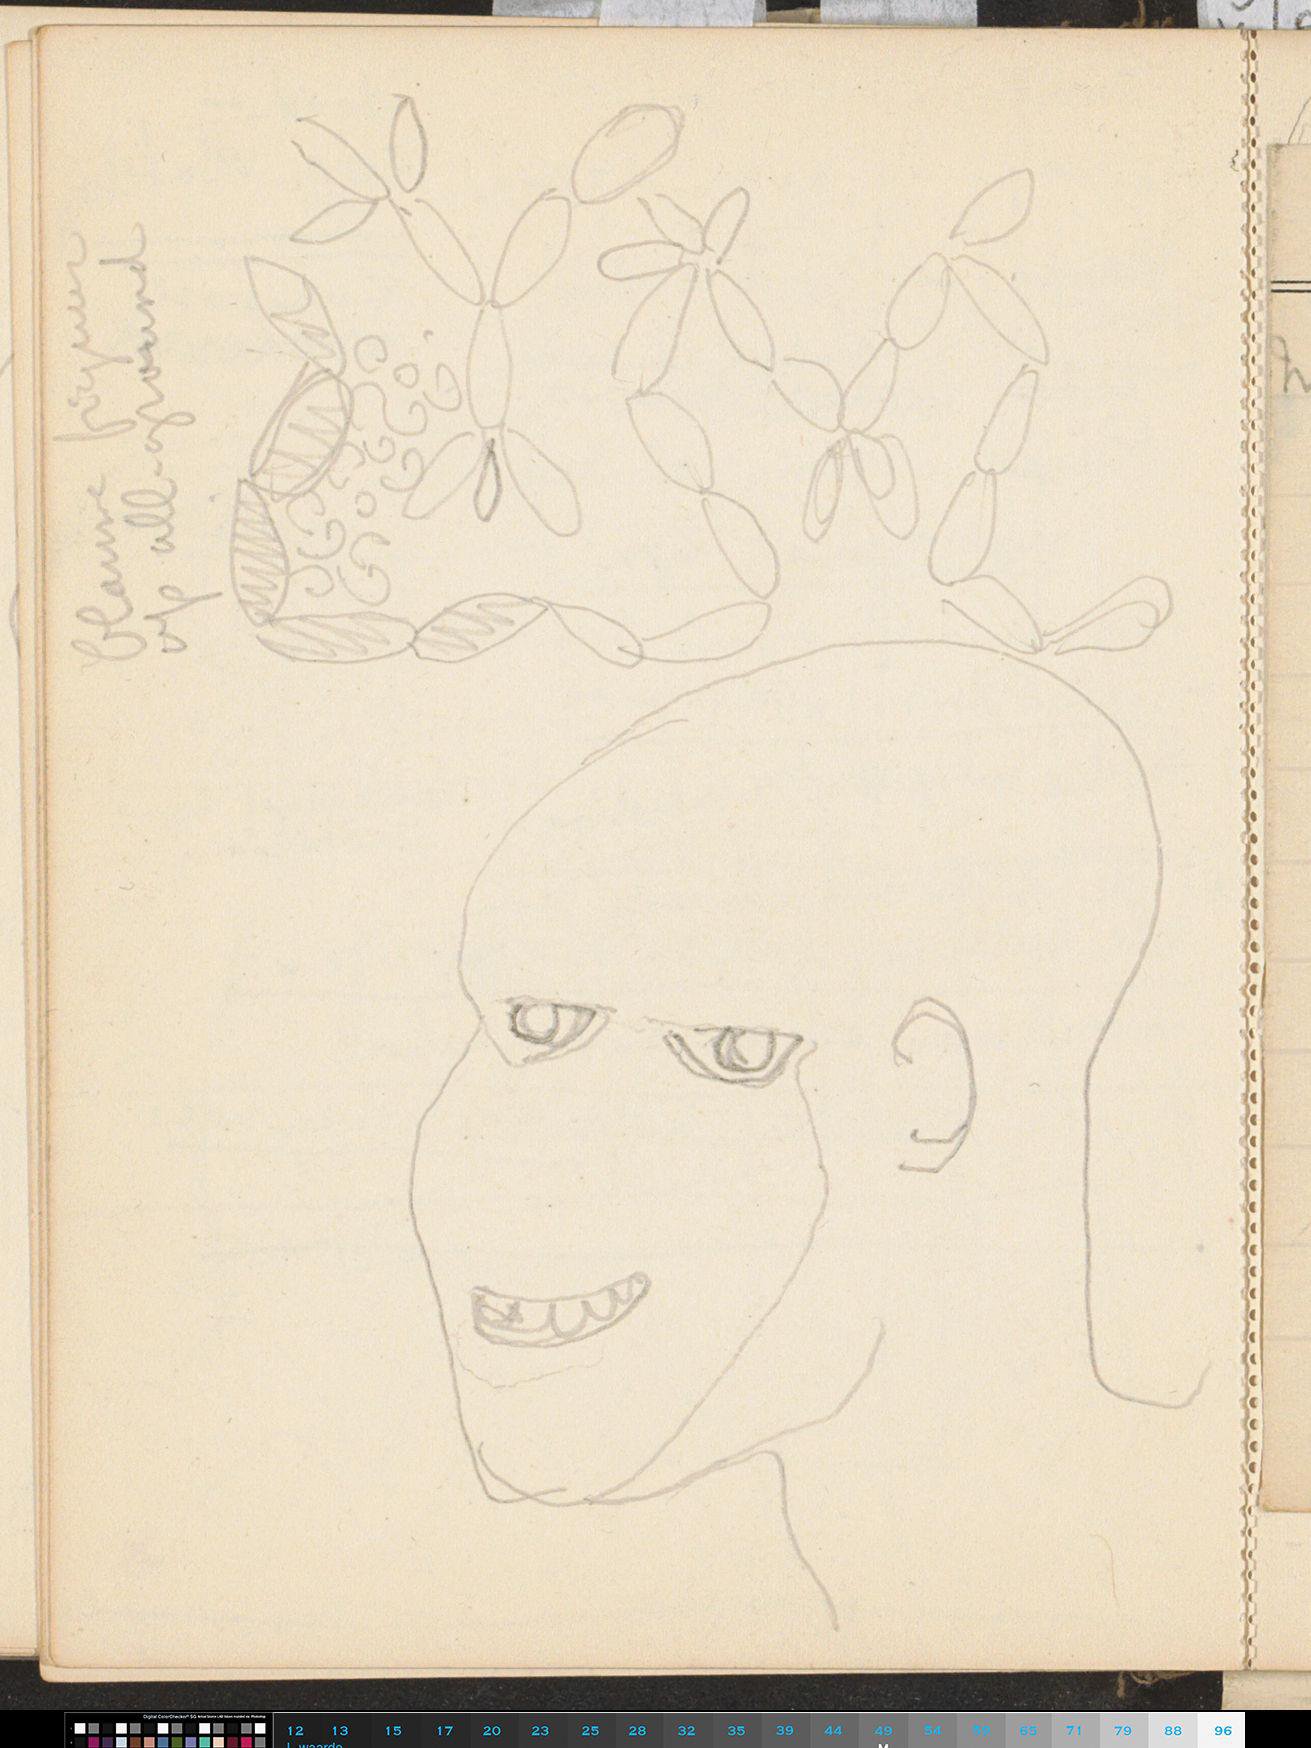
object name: sketchbook leaf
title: Bloemenpatroon en een kaal hoofd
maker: reijer stolk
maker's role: draughtsman, print maker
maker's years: 1896-1945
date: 1916-1945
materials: paper, pencil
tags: flowers, head (human), baldness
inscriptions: kleurnotitie, handgeschreven in potlood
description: Blad 26 verso uit een schetsboek met 60 bladen.